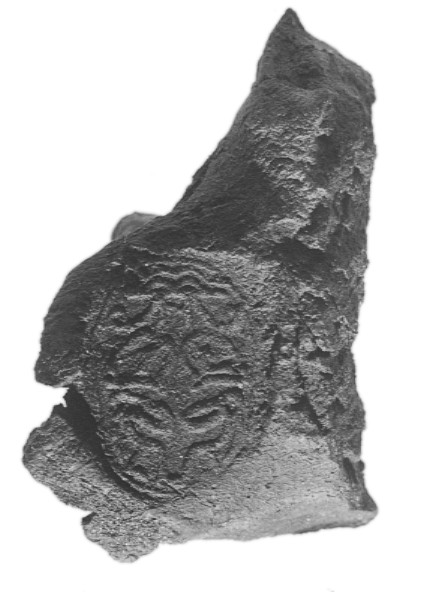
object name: sealing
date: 2030-1640 BCE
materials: clay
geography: egypt